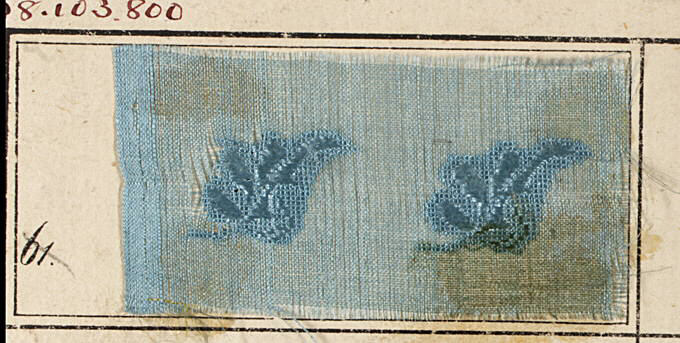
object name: ribbon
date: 1701-1900